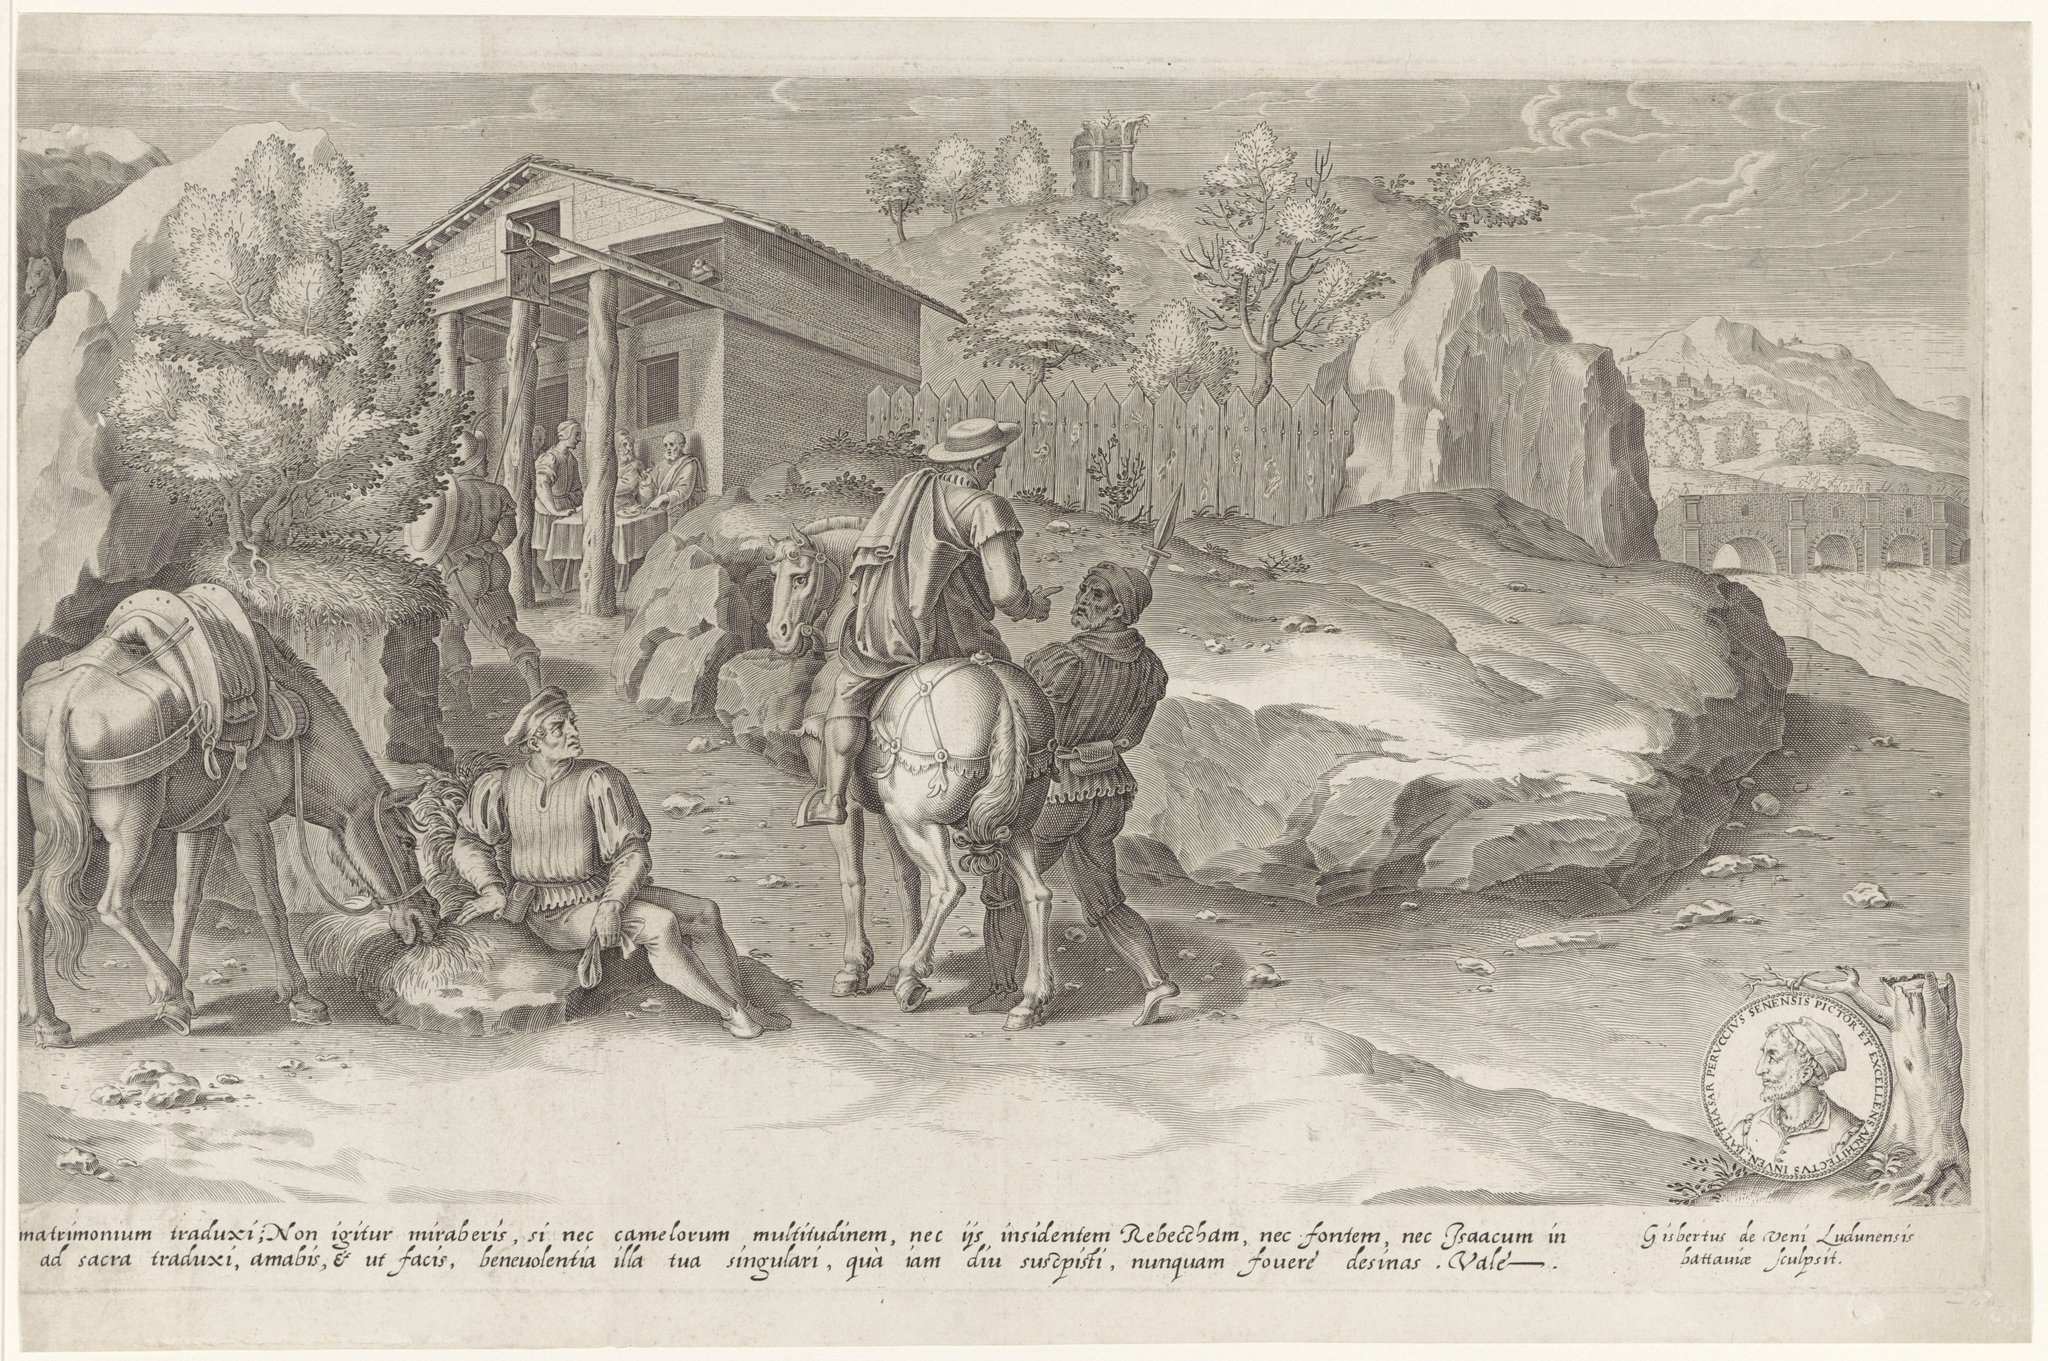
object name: print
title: Huwelijk van Isaak en Rebekka (blad 4)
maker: gijsbert van veen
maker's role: print maker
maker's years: 1562-1628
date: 1585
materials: paper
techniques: engraving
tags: marriage of isaac and rebekah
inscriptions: collector's mark: Lugt 2228, inscription: ‘F’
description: Rechter blad van een voorstelling van het huwelijk van Isaak en Rebekka, bestaande uit vier bladen gedrukt van vier platen.